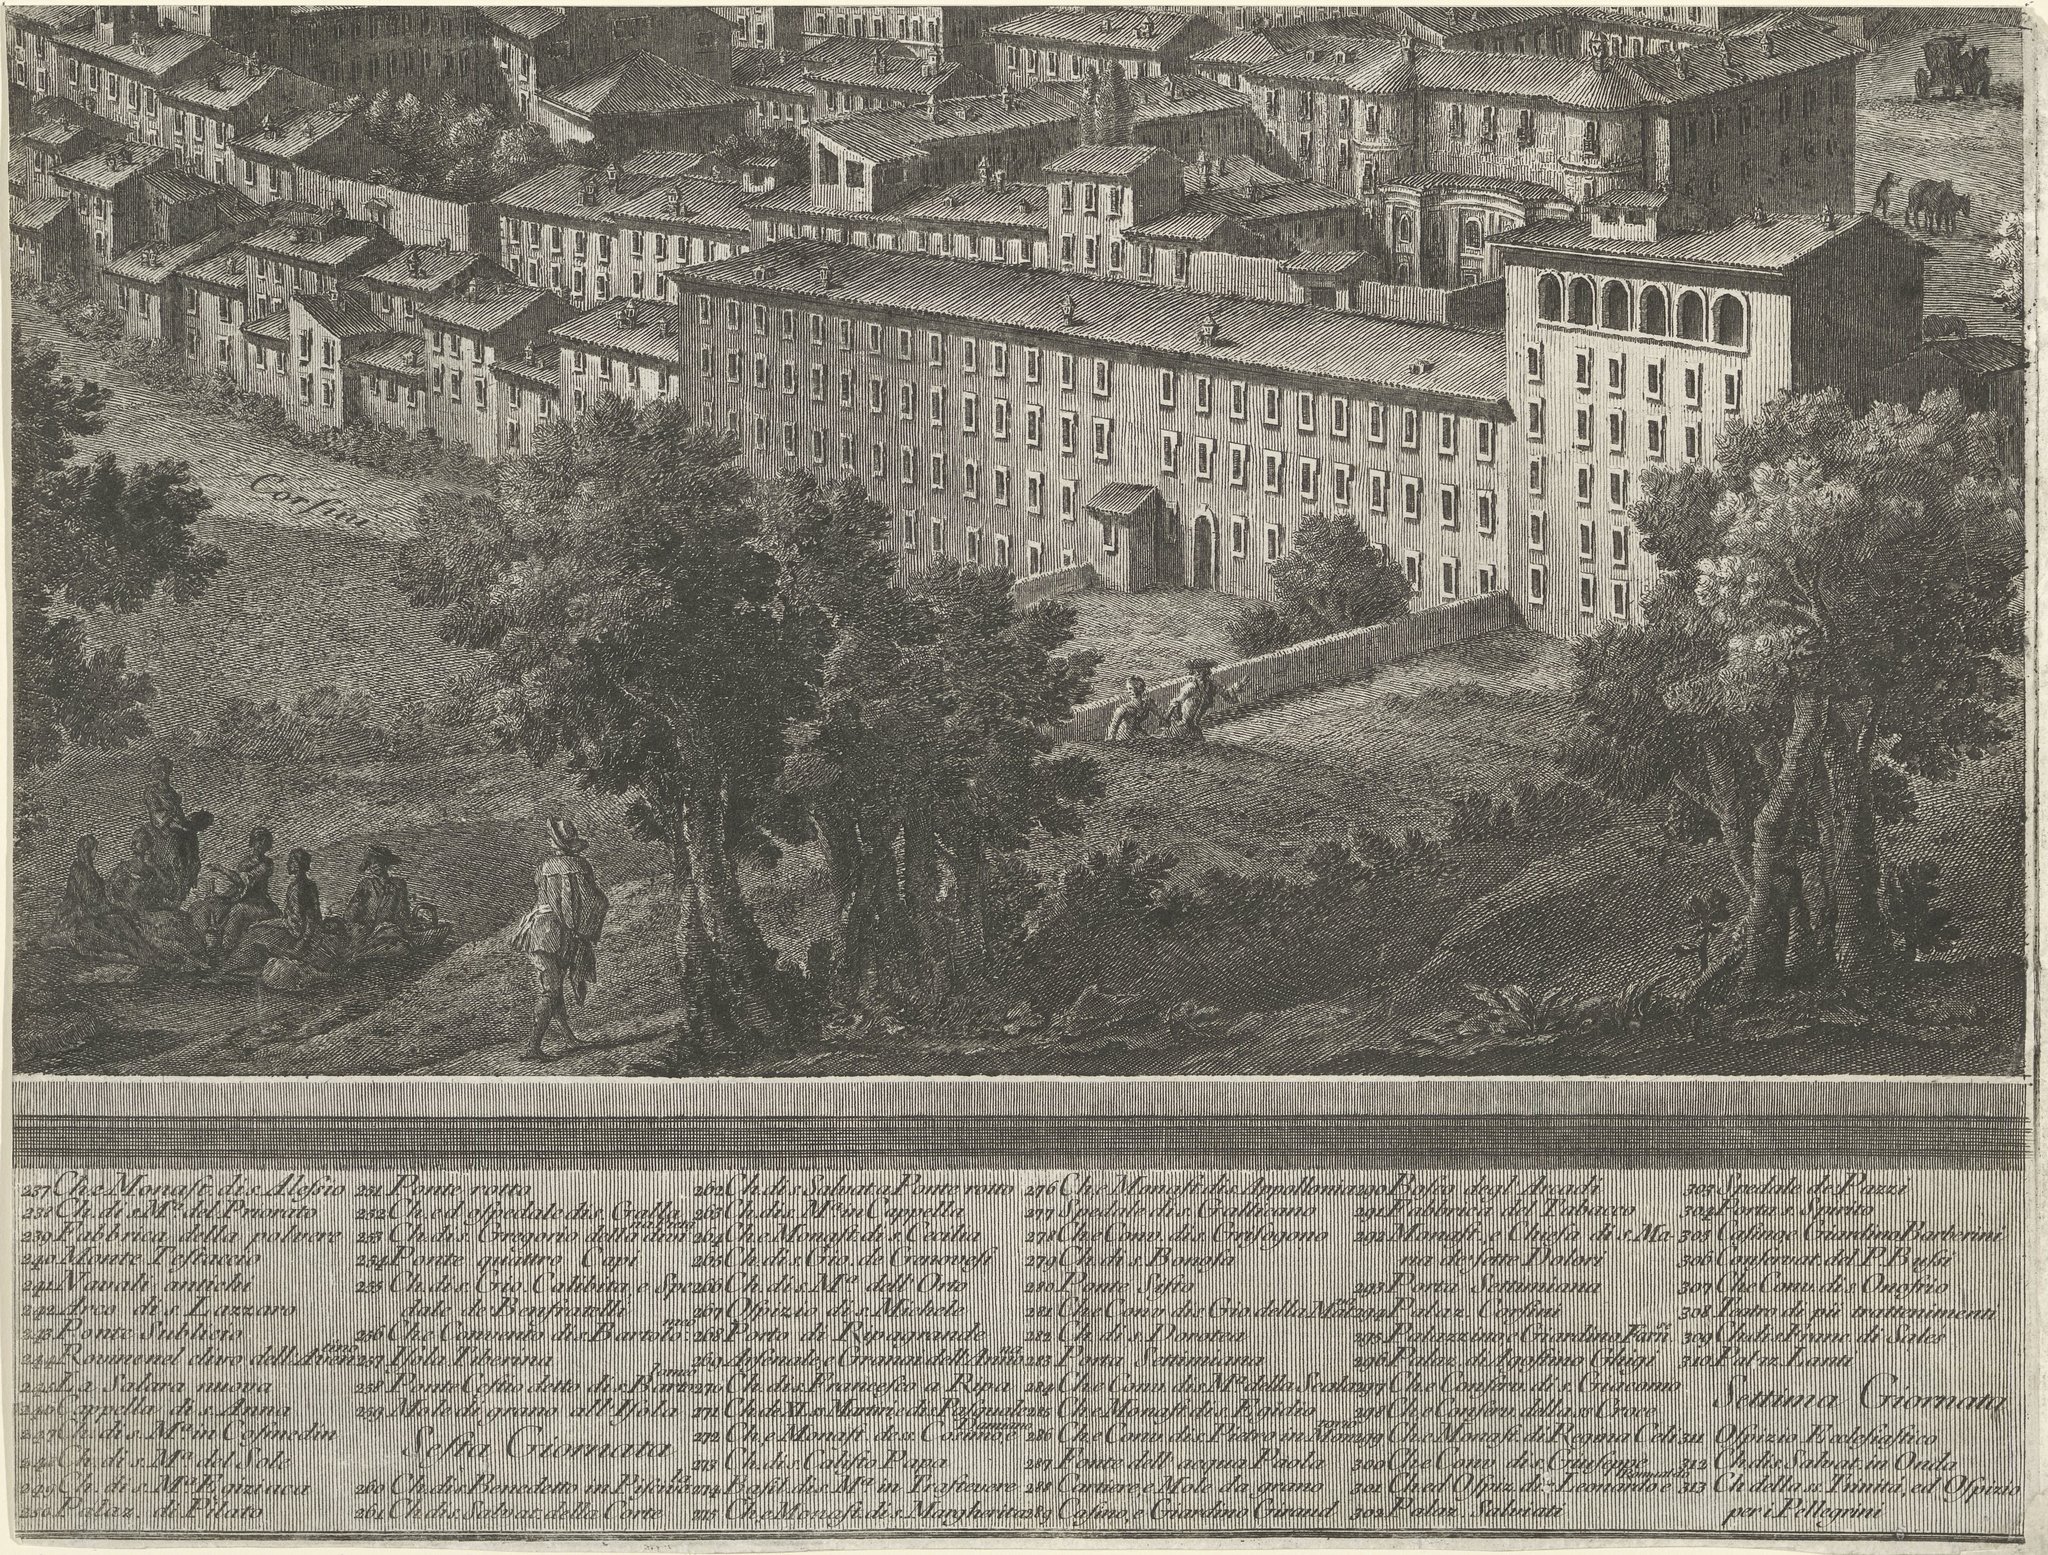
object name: print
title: Panorama van de stad Rome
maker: giuseppe vasi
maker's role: draughtsman, painter, print maker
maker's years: 1710-1782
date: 1765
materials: paper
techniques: etching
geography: rome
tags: panorama, cyclorama, city-view in general; 'veduta', rome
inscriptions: collector's mark: Lugt 2228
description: Deel van een panorama van de stad Rome, gezien vanaf de Janiculum heuvel. Verklarende lijst met nummers in ondermarge.